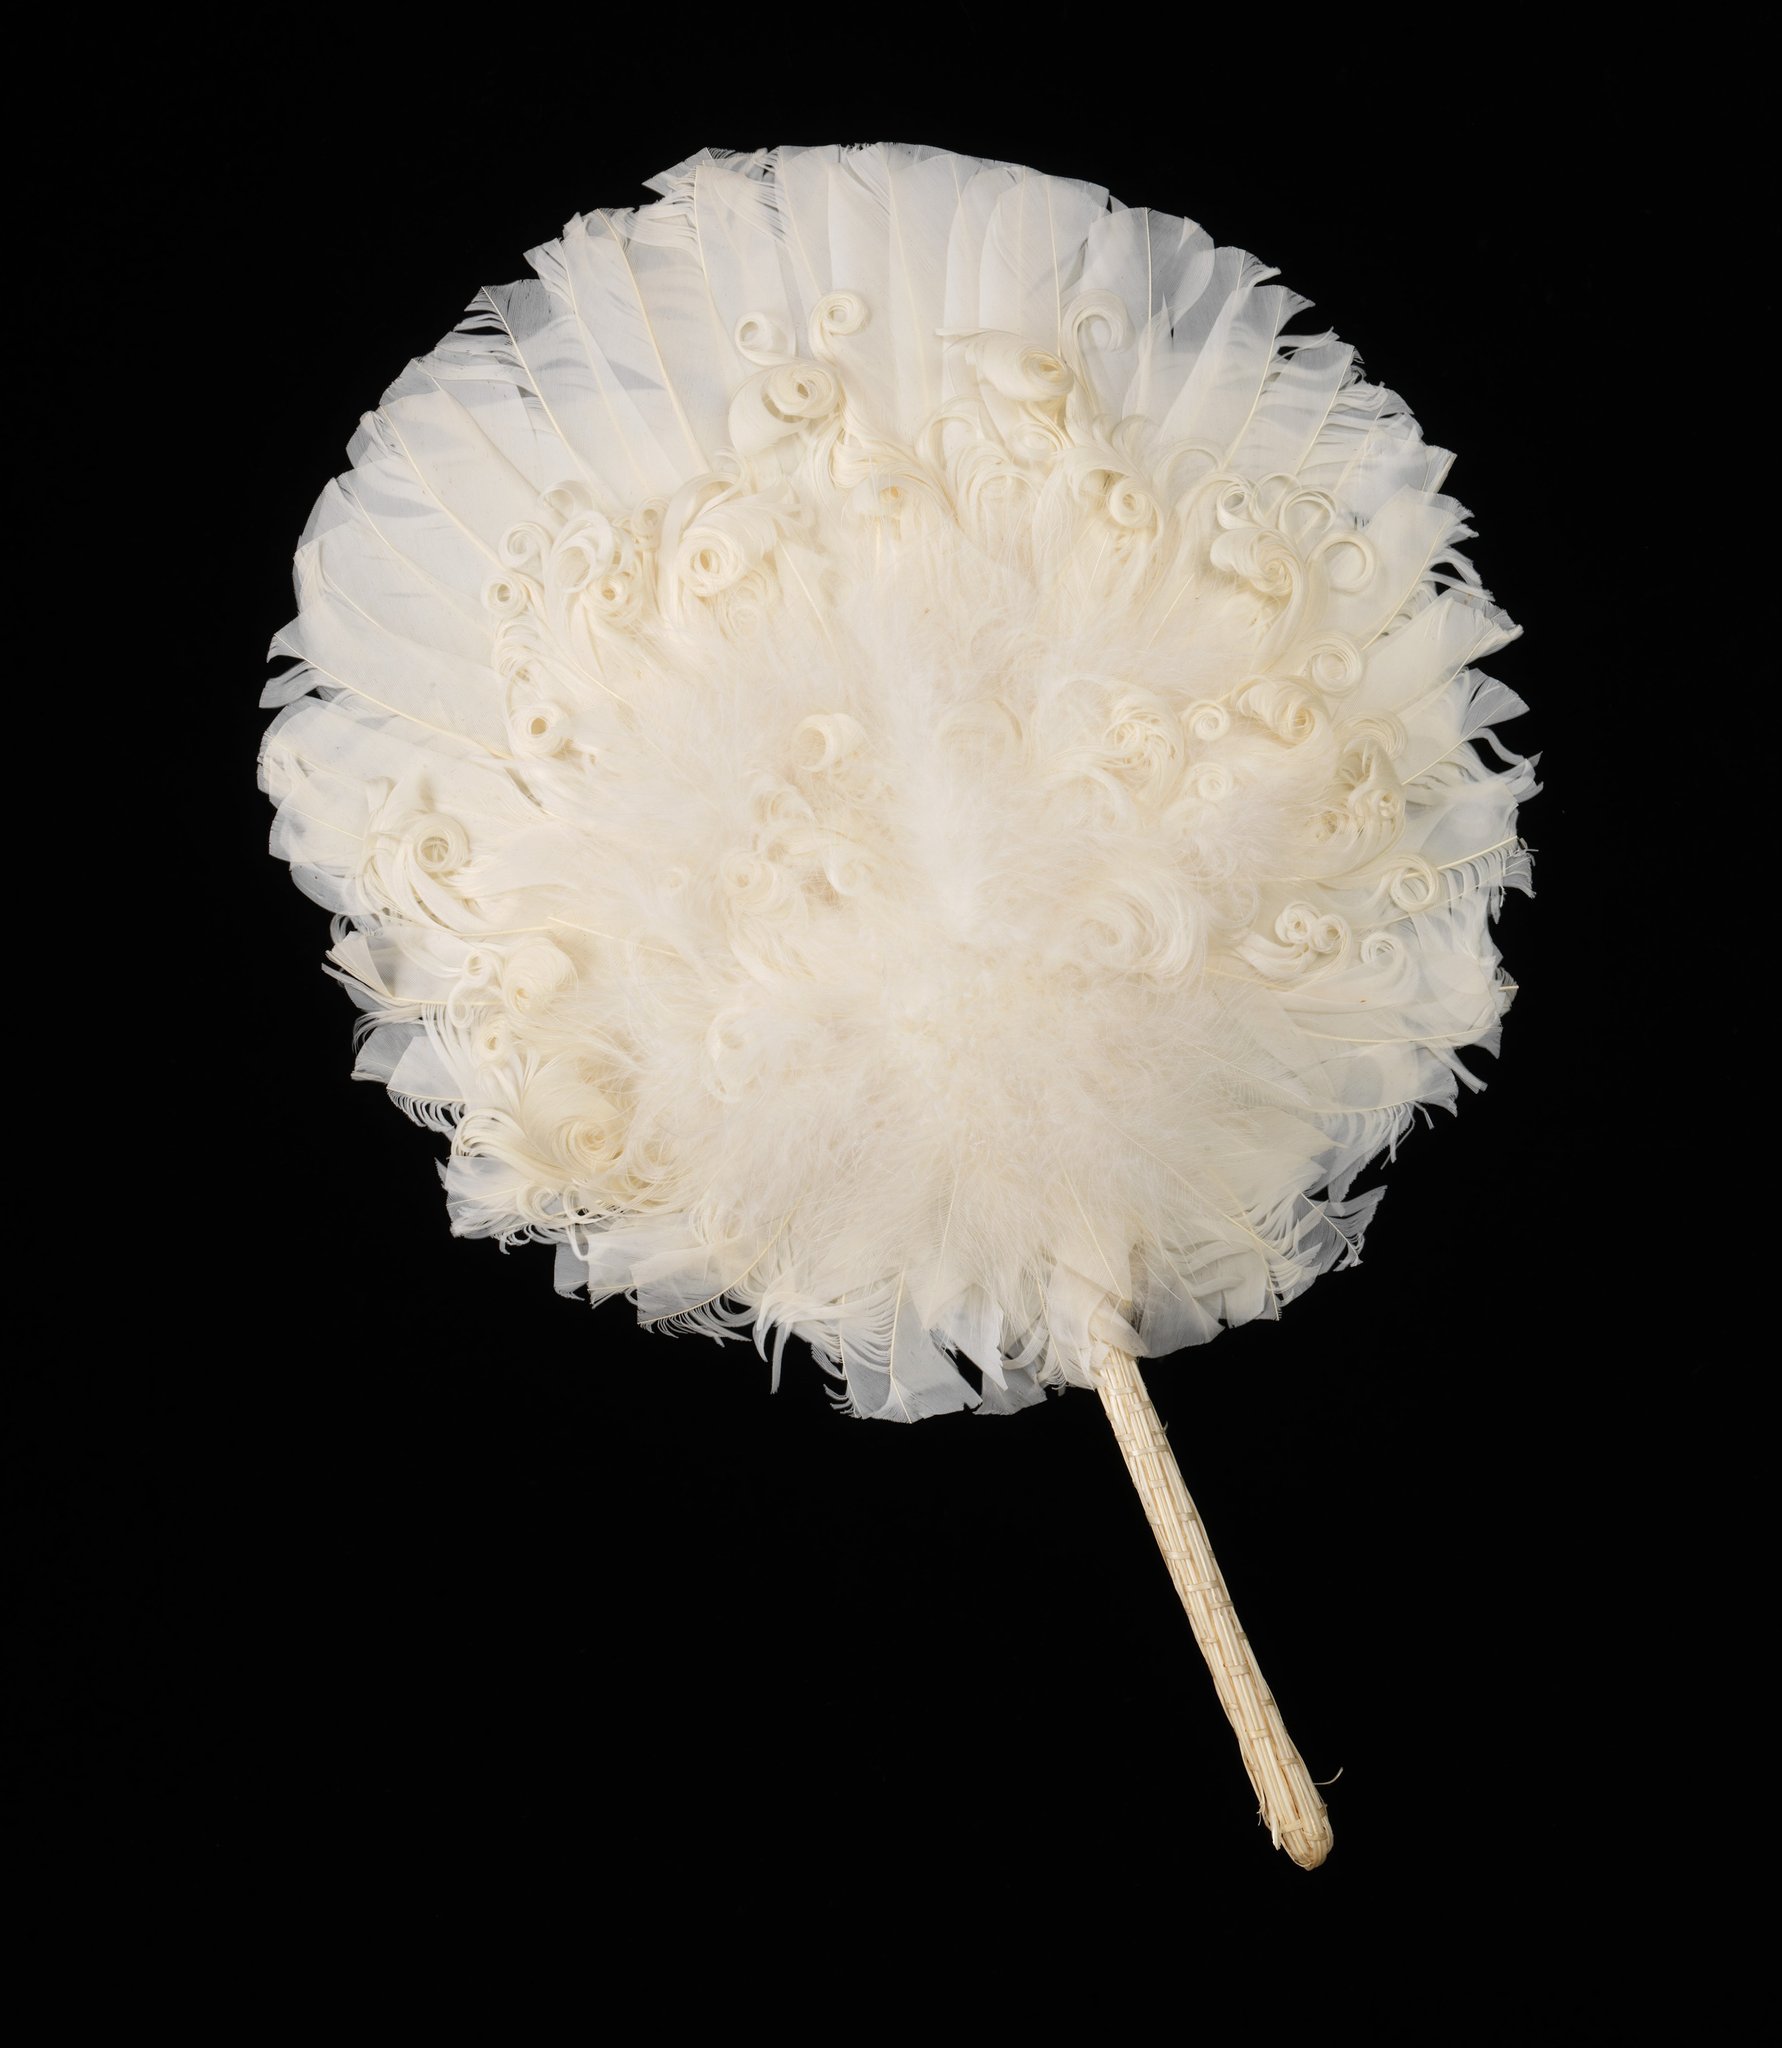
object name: fixed fan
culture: american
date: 1875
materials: feather, fiber